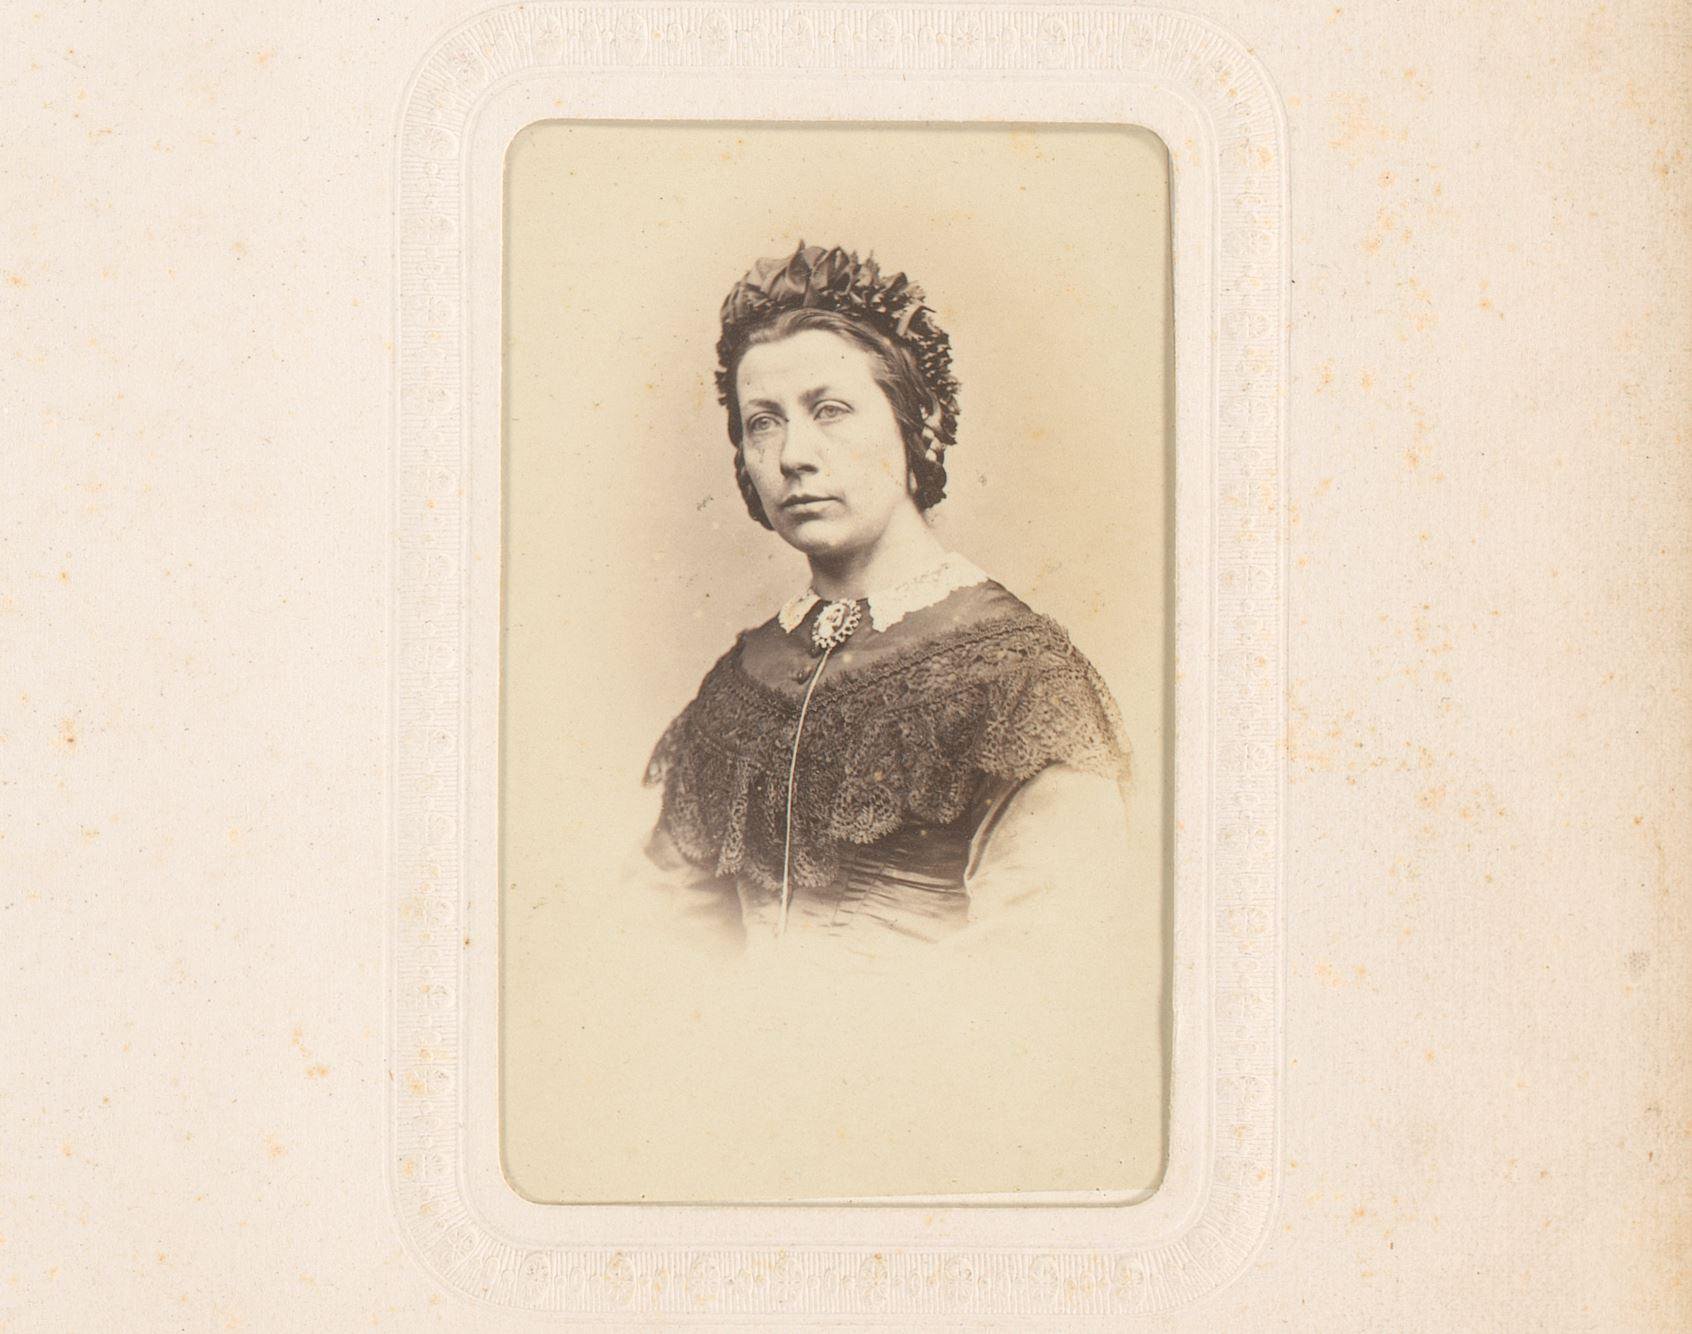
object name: photograph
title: Portret van een vrouw met muts en medaillon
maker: Anonymous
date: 1860-1900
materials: cardboard, photographic support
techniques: albumen print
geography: netherlands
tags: historical persons - bb - woman, pendant, trinket, 'breloque', old woman, head-gear: cap